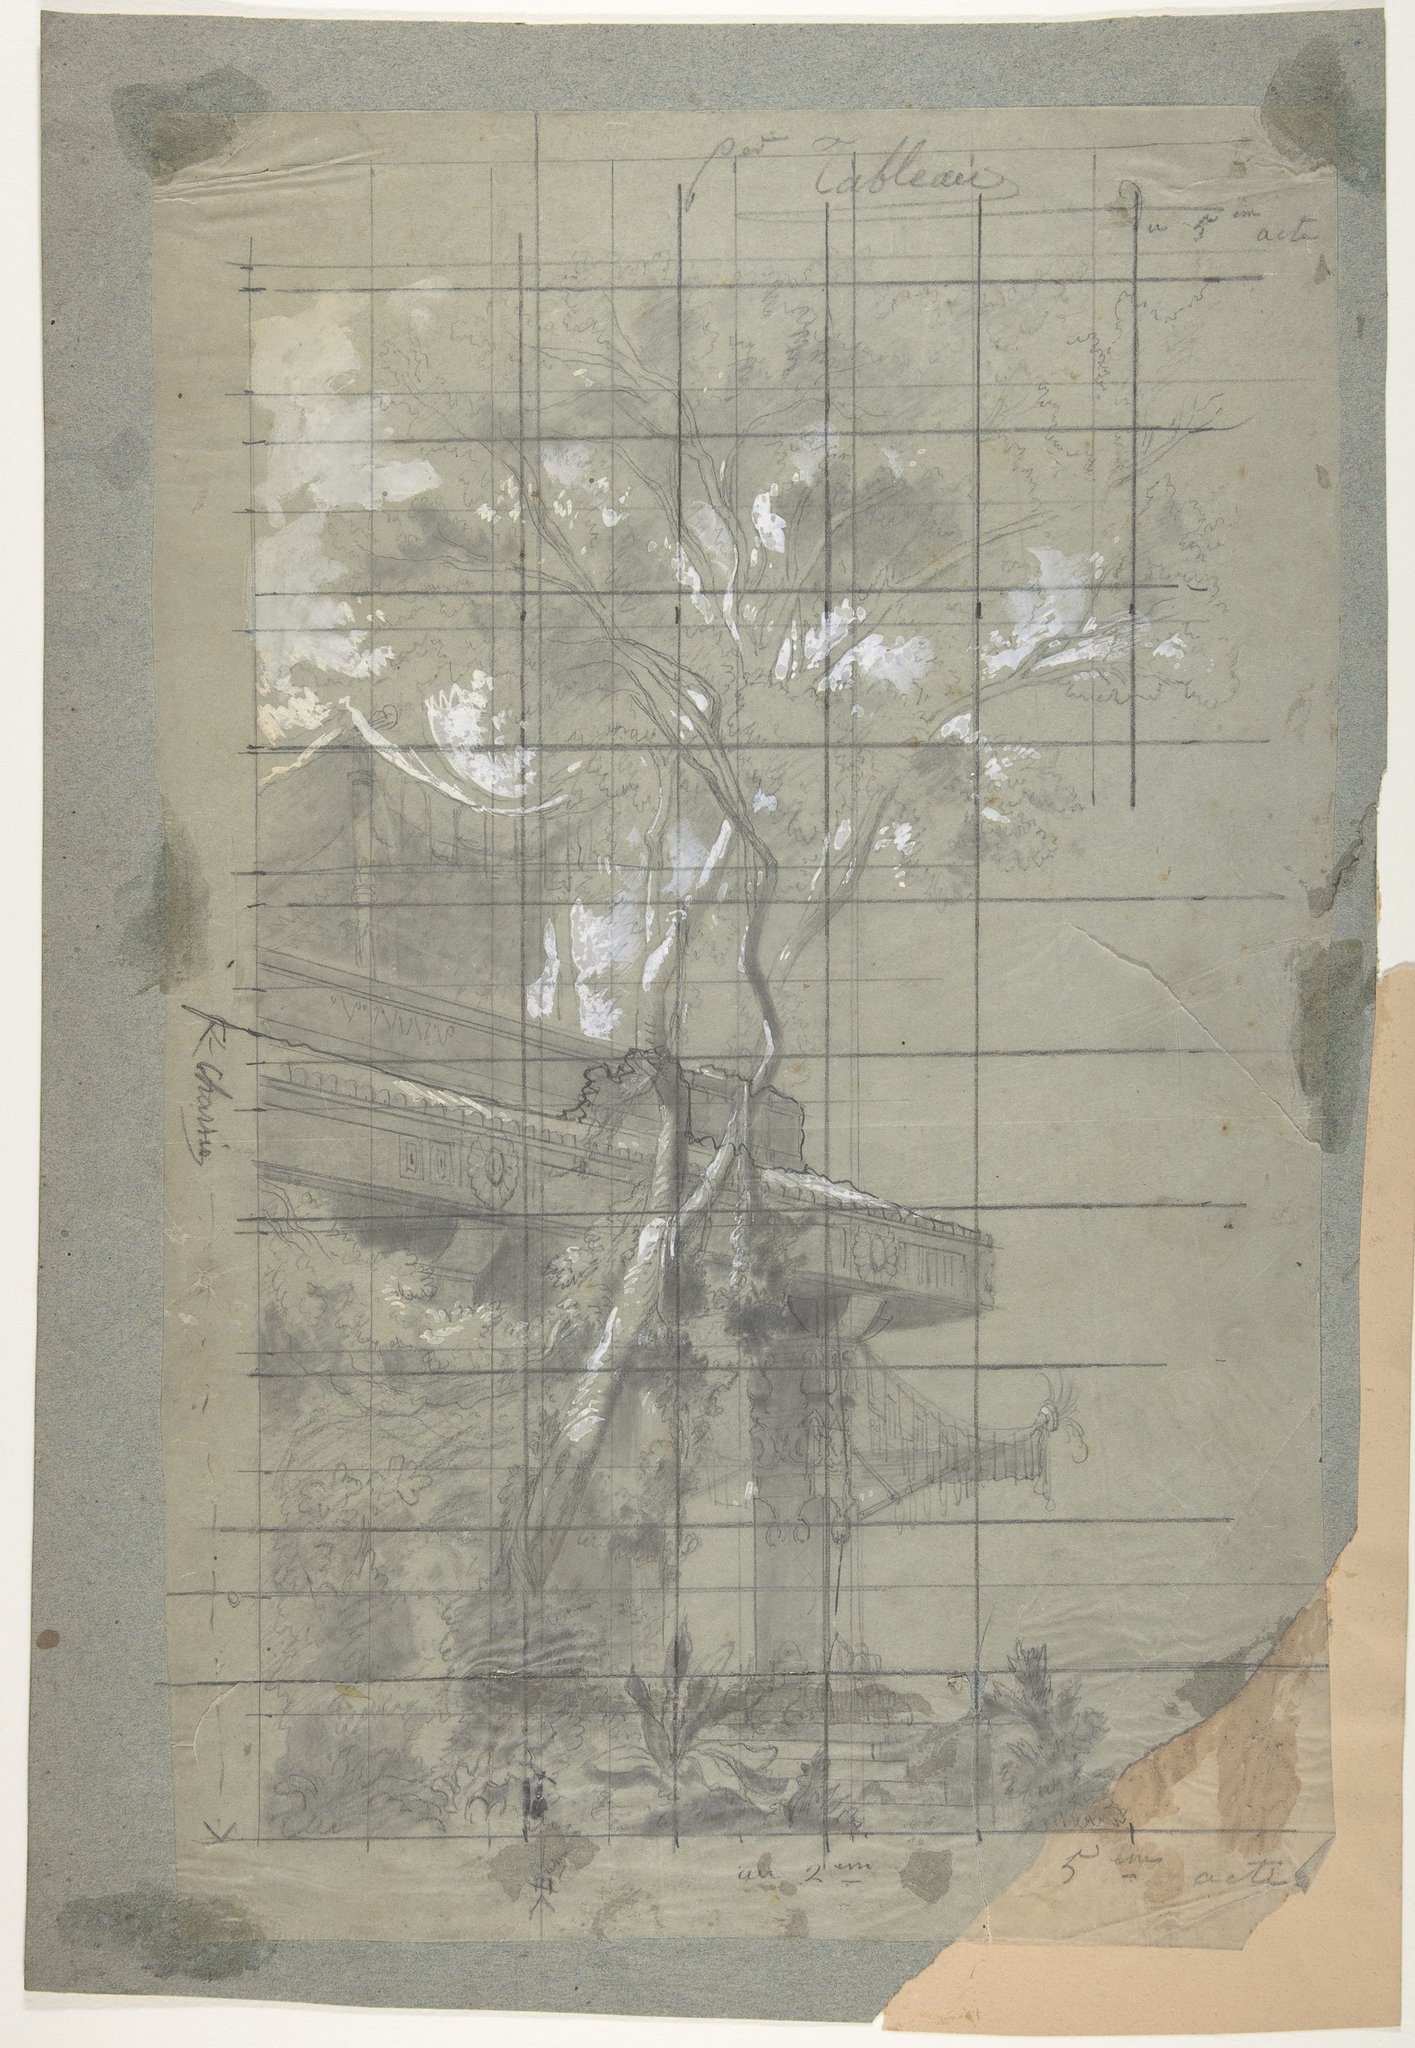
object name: drawing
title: Design for a Stage Set at the Opéra, Paris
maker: eugène cicéri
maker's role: artist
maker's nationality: french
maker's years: 1813-1890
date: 1830-1890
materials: graphite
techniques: heightening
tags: stage design